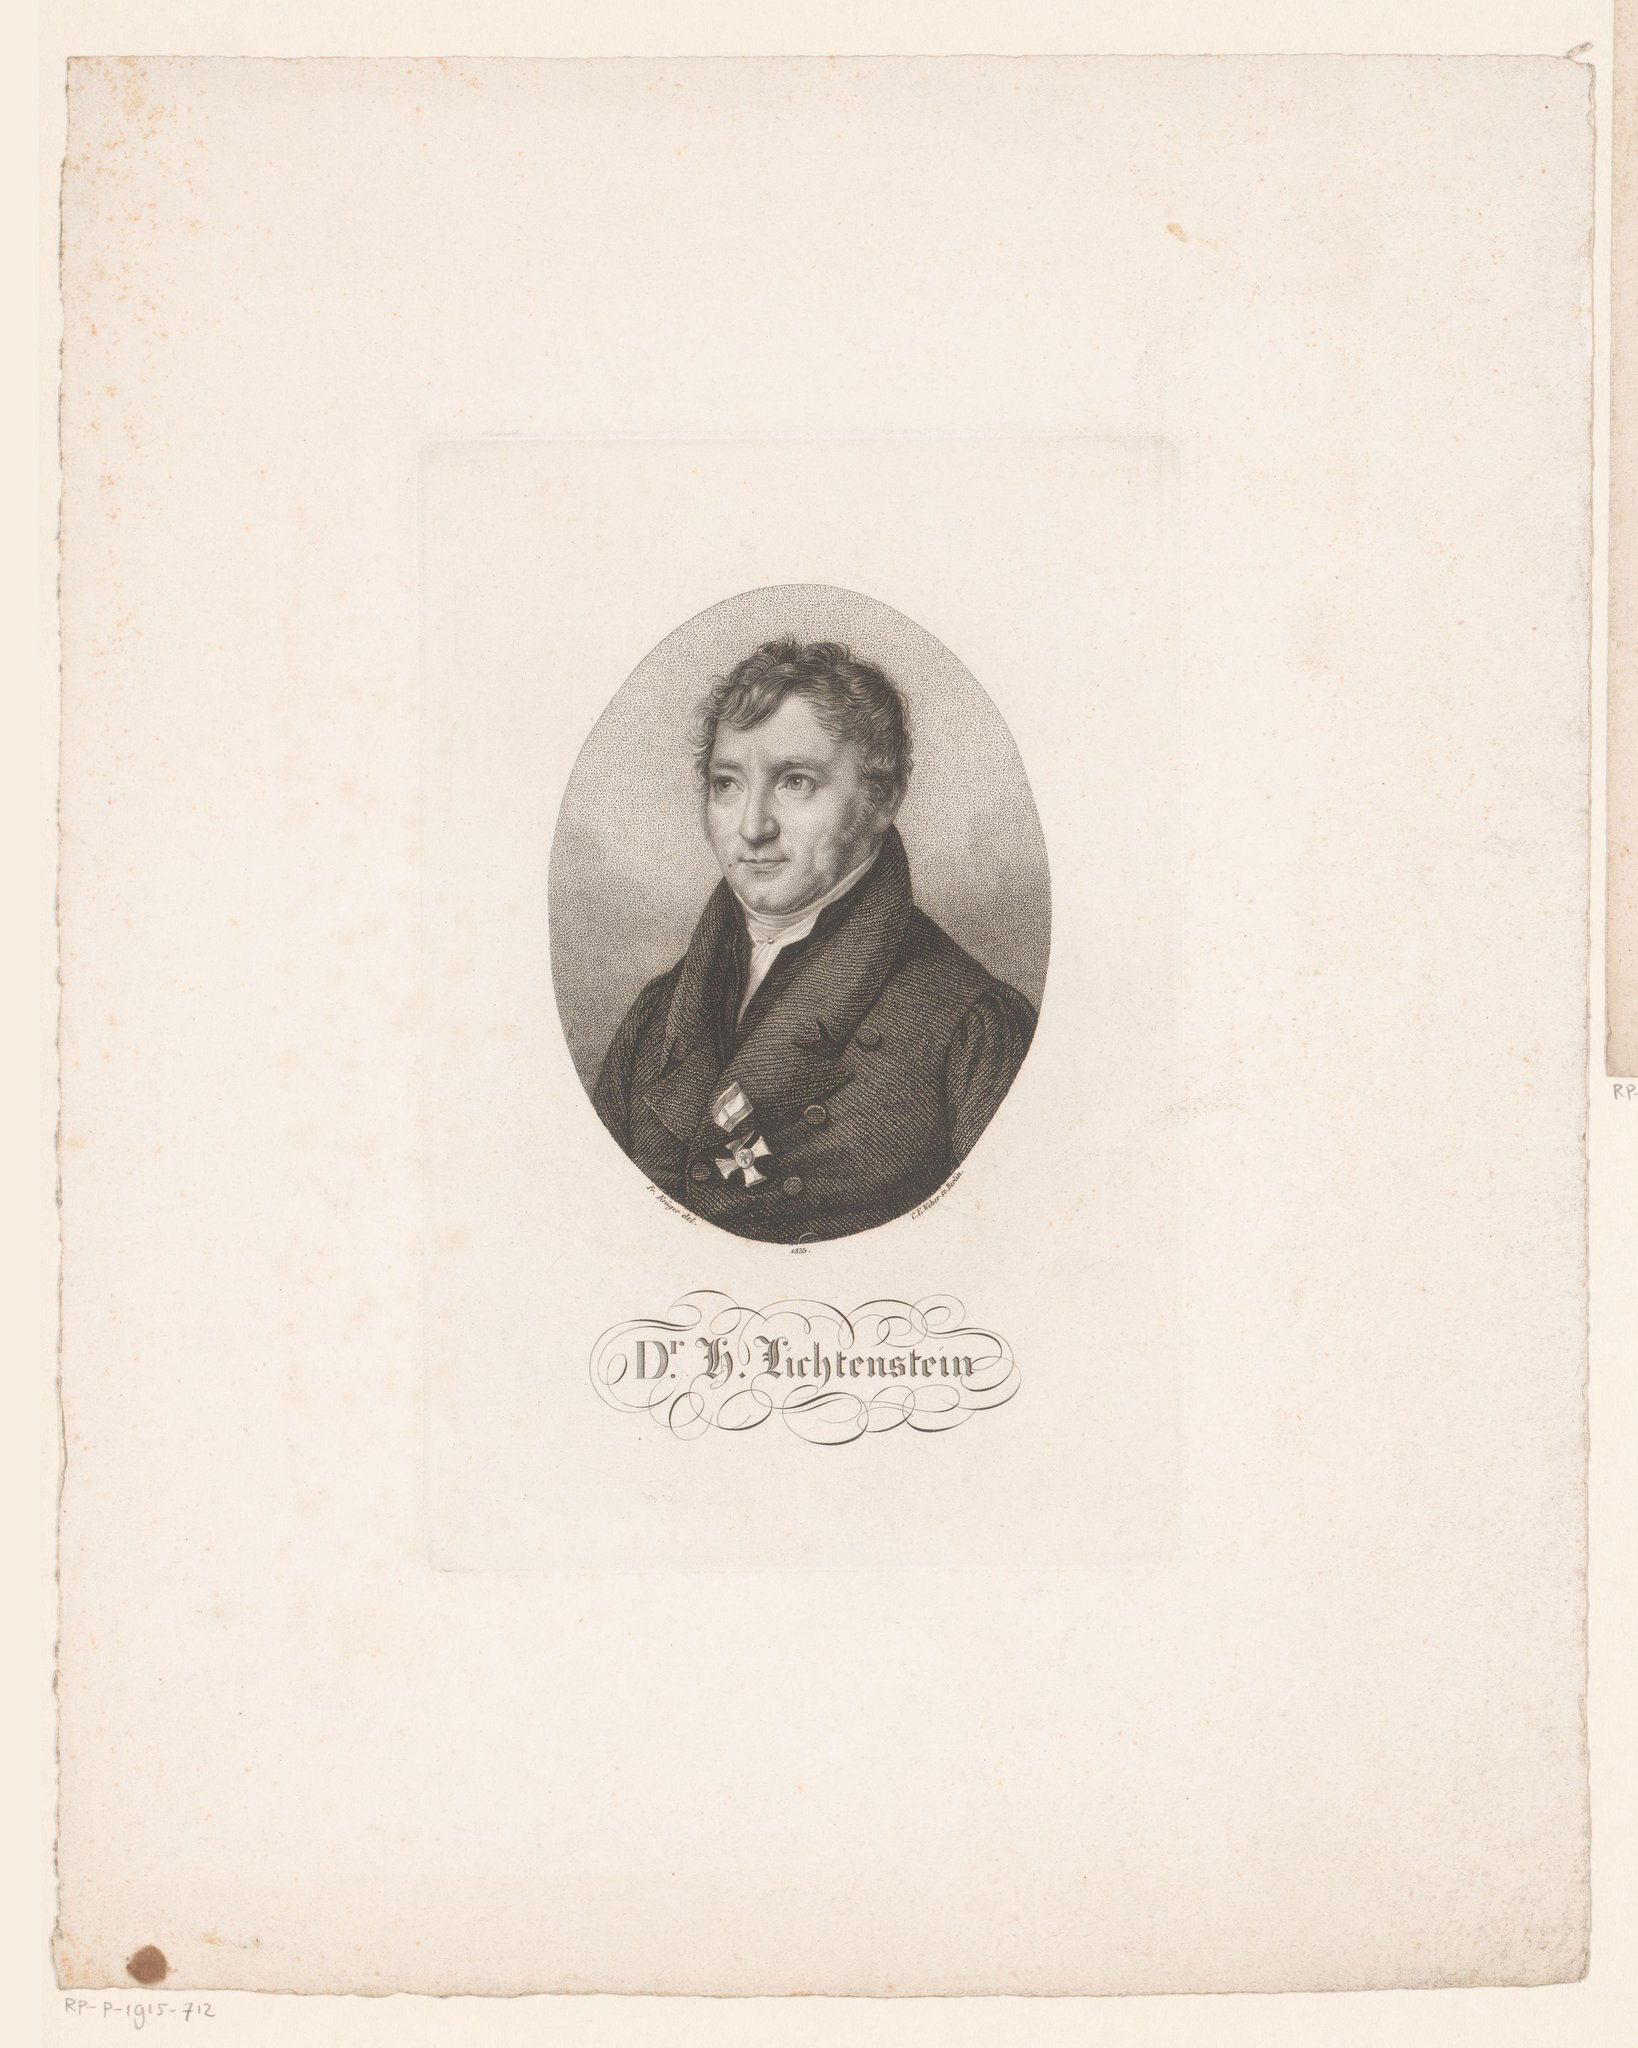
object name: print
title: Portret van Martin Hinrich Lichtenstein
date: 1833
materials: paper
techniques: engraving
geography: berlin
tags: historical persons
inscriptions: collector's mark: Lugt 2228